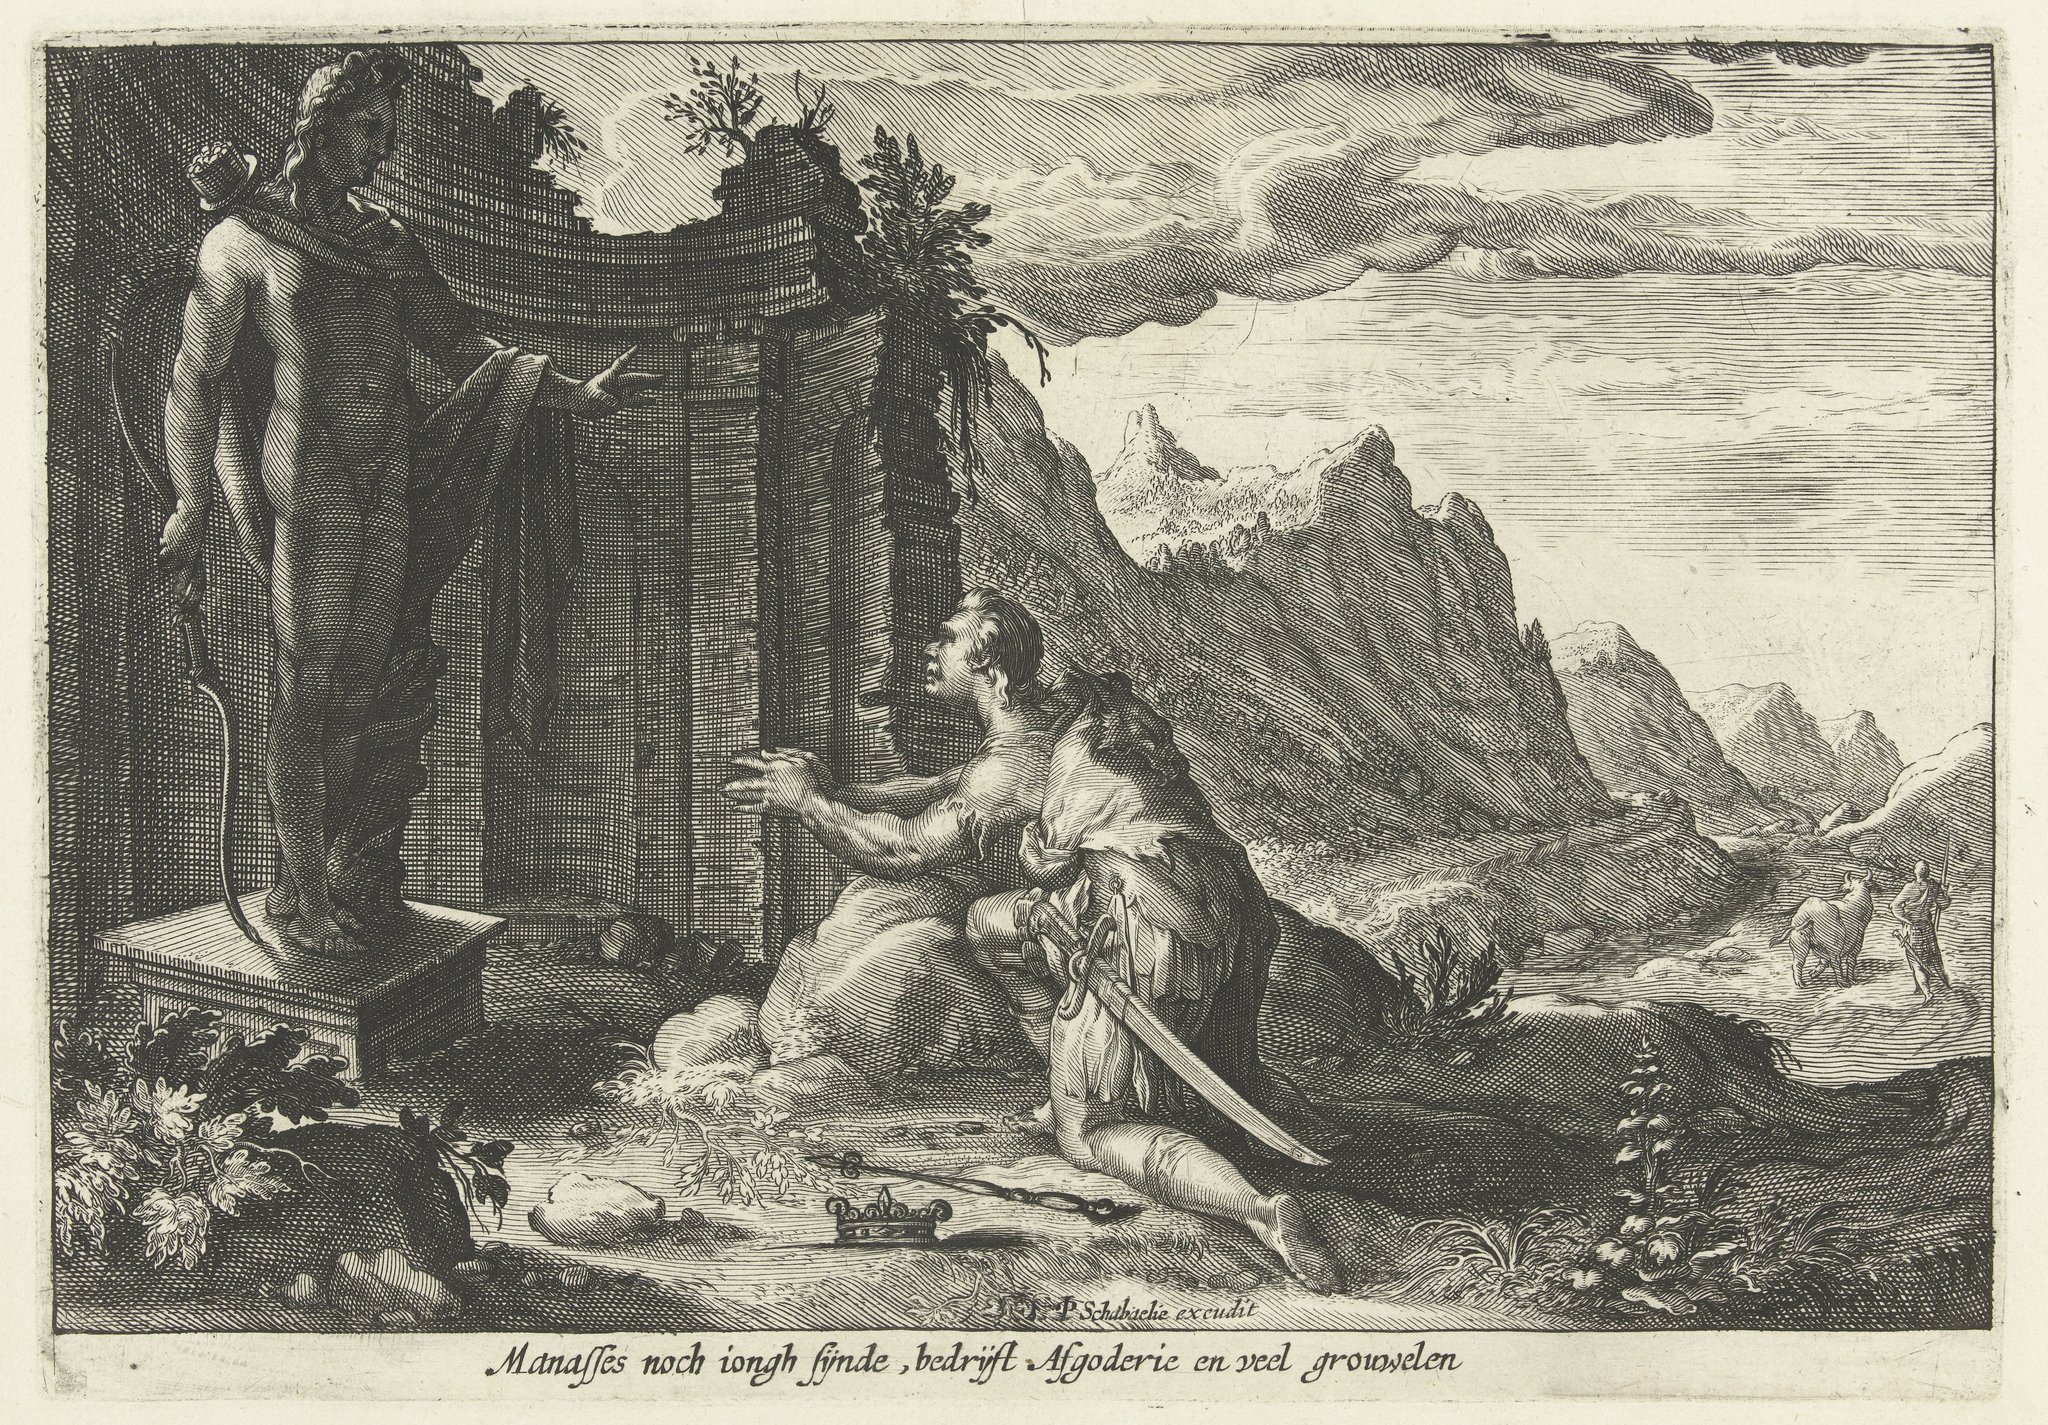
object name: print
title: Koning Manasse vereert een afgodsbeeld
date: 1648-1656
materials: paper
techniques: engraving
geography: amsterdam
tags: manasseh's apostasy, cadmus meets the cow which leads him into boeotia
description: Deze prent is een kopie naar een prent uit de ateliers van Hendrick Goltzius en Robert de Baudous, die onderdeel is van een serie van 52 prenten die verhalen uit Ovidius' Metamorfosen verbeelden. Het voorbeeld heeft geen betrekking op Manasse en een afgodsbeeld, maar op Cadmus en het orakel van Delphi. Klinkert, C.